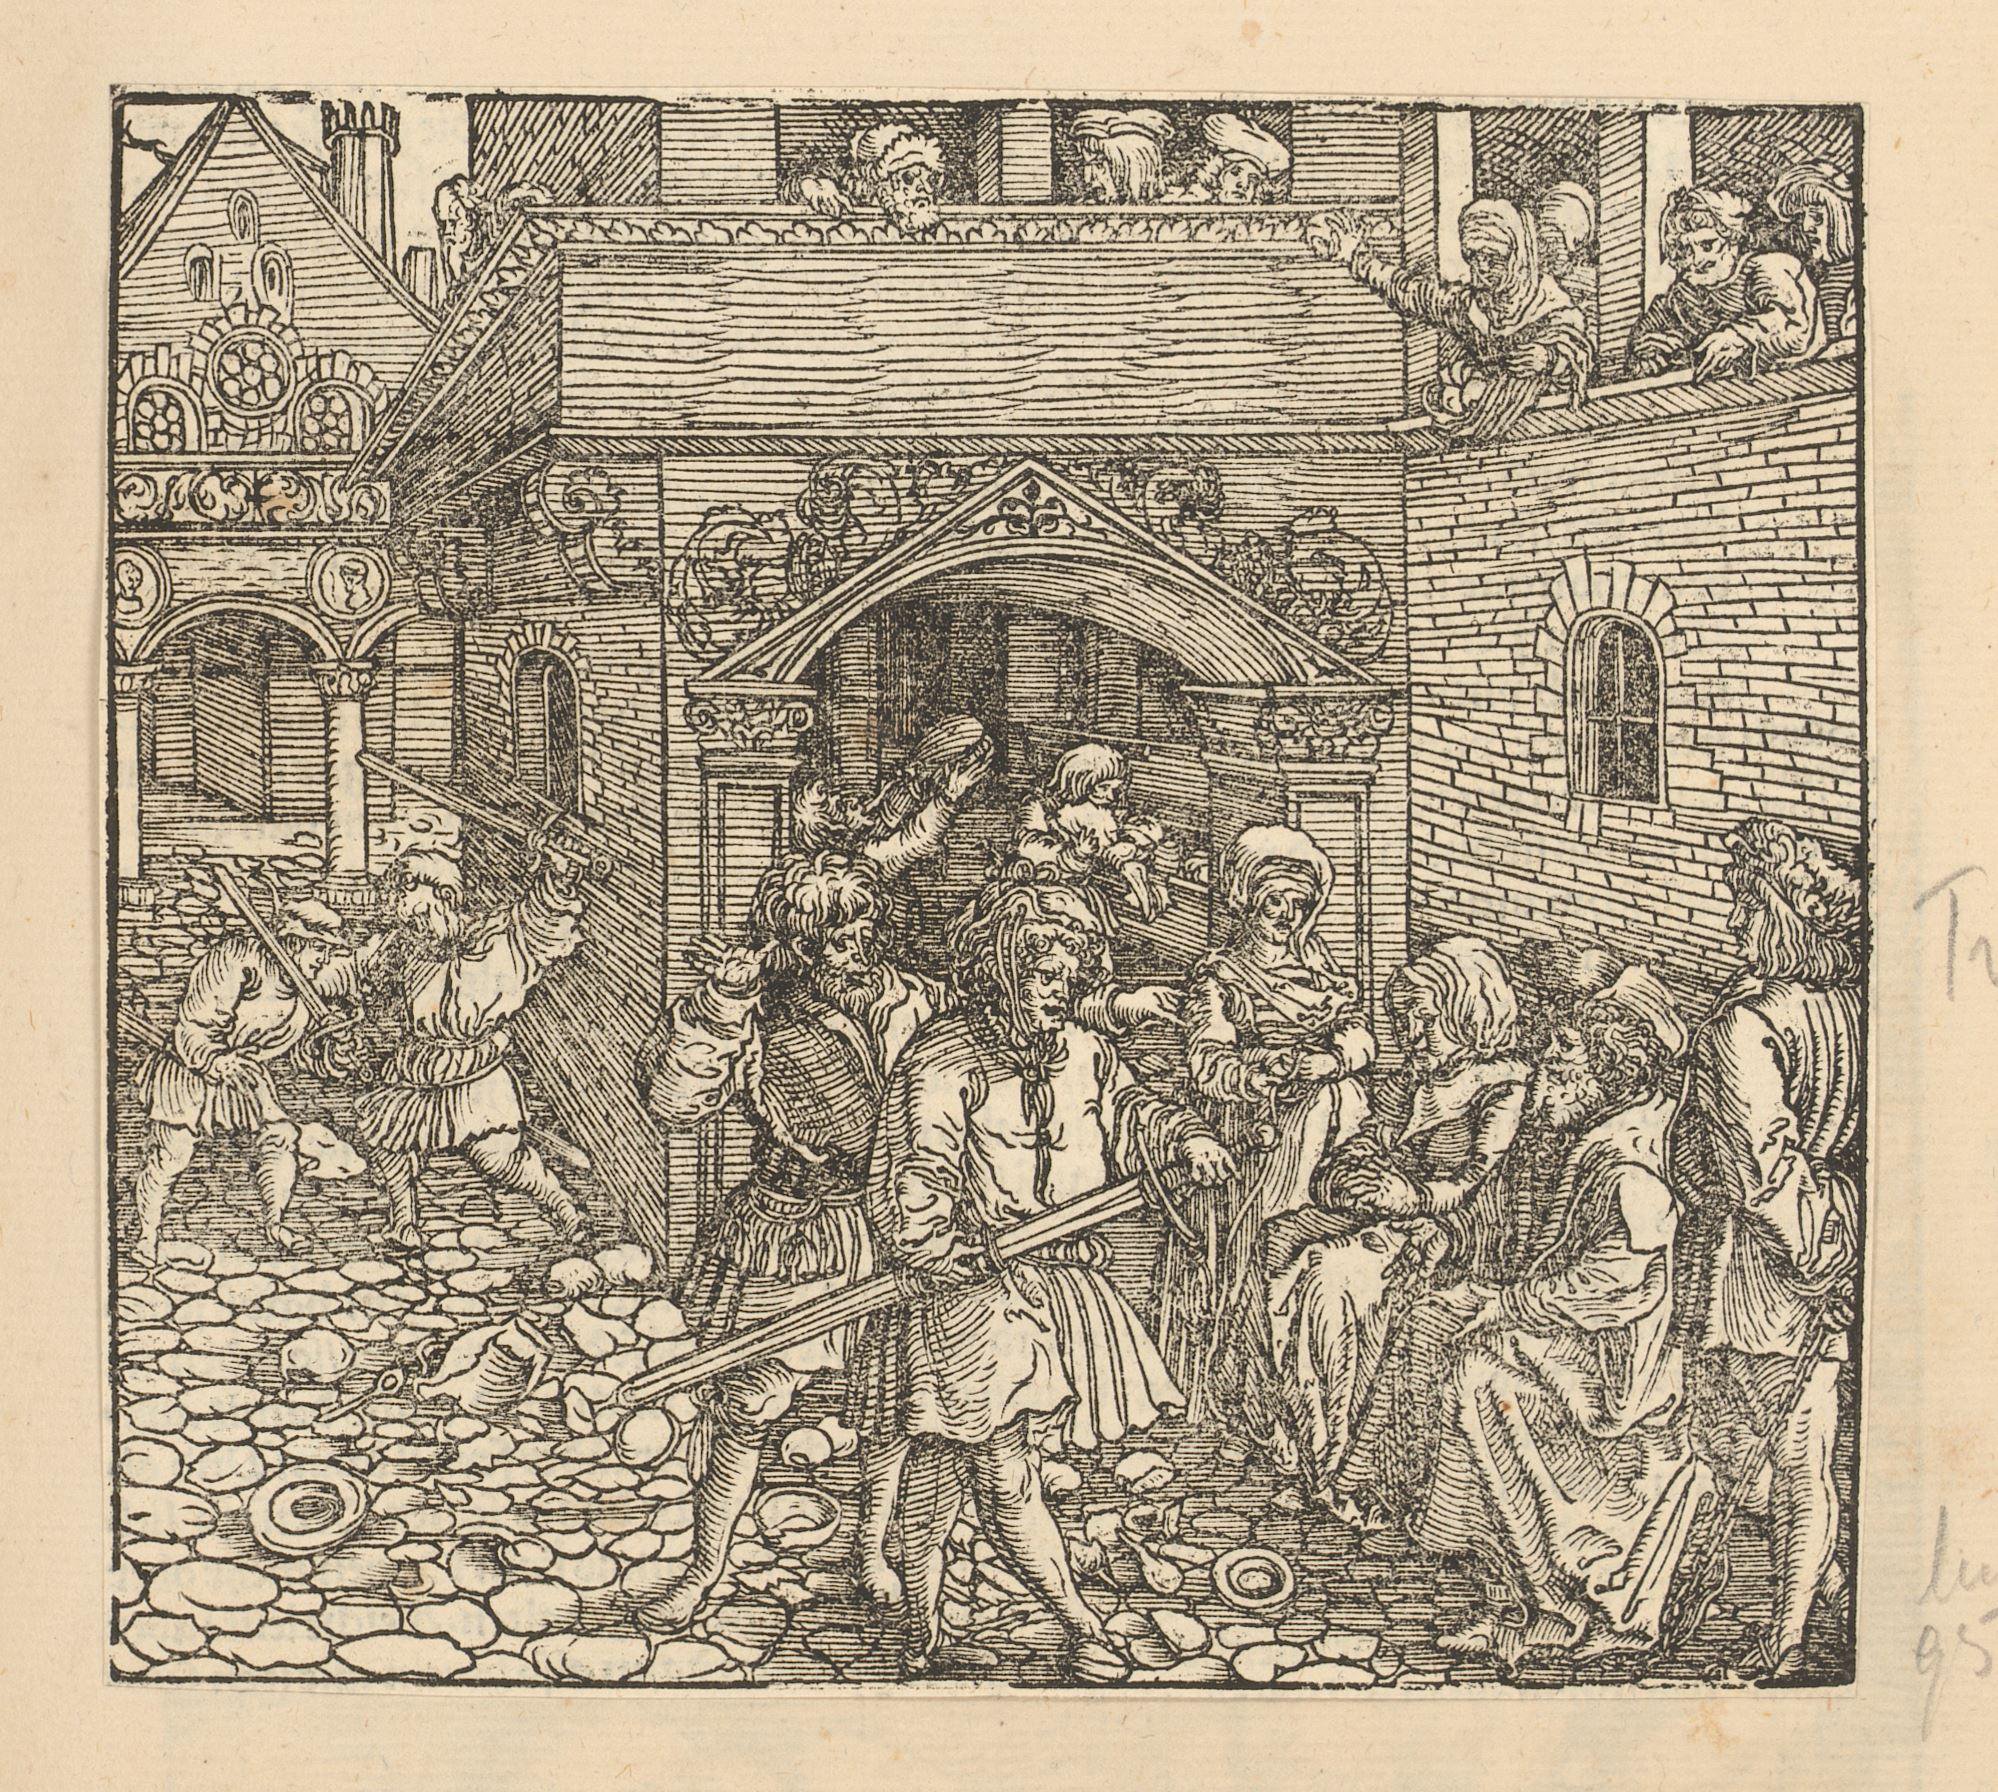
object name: album leaf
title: Gewapende mannen in een dorp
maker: Anonymous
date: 1514-1532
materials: paper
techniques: letterpress printing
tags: plundering ~ riot, drunken brawl (usually peasants fighting in an inn), house personnel, servants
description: Deze prent is gebruikt in: Petrarca, Francesco. Von der Artzney bayder Glück, des guten und widerwertigen: unnd weß sich ain yeder inn Gelück und Unglück halten sol (...). Augsburg: Heinrich Steiner, 1532. Deze uitgave is ook bekend onder de titel 'Trostspiegel in Glück und Unglück'.